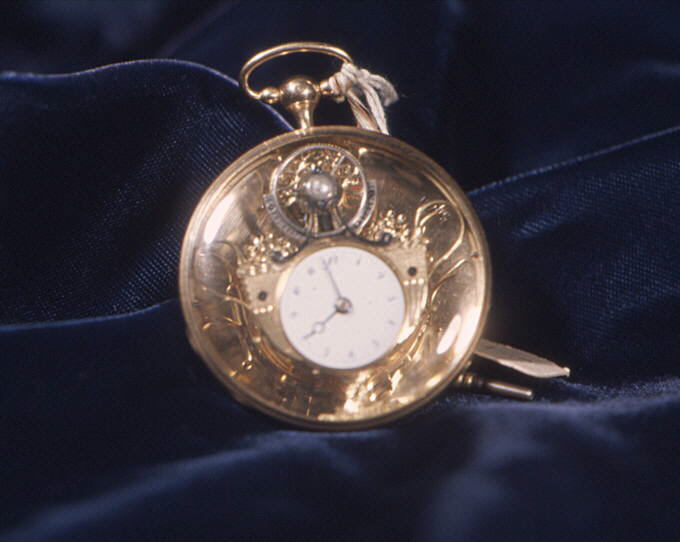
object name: skeleton watch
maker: thomasson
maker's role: maker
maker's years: 1804-1810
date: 1801-1900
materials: enamel, gold